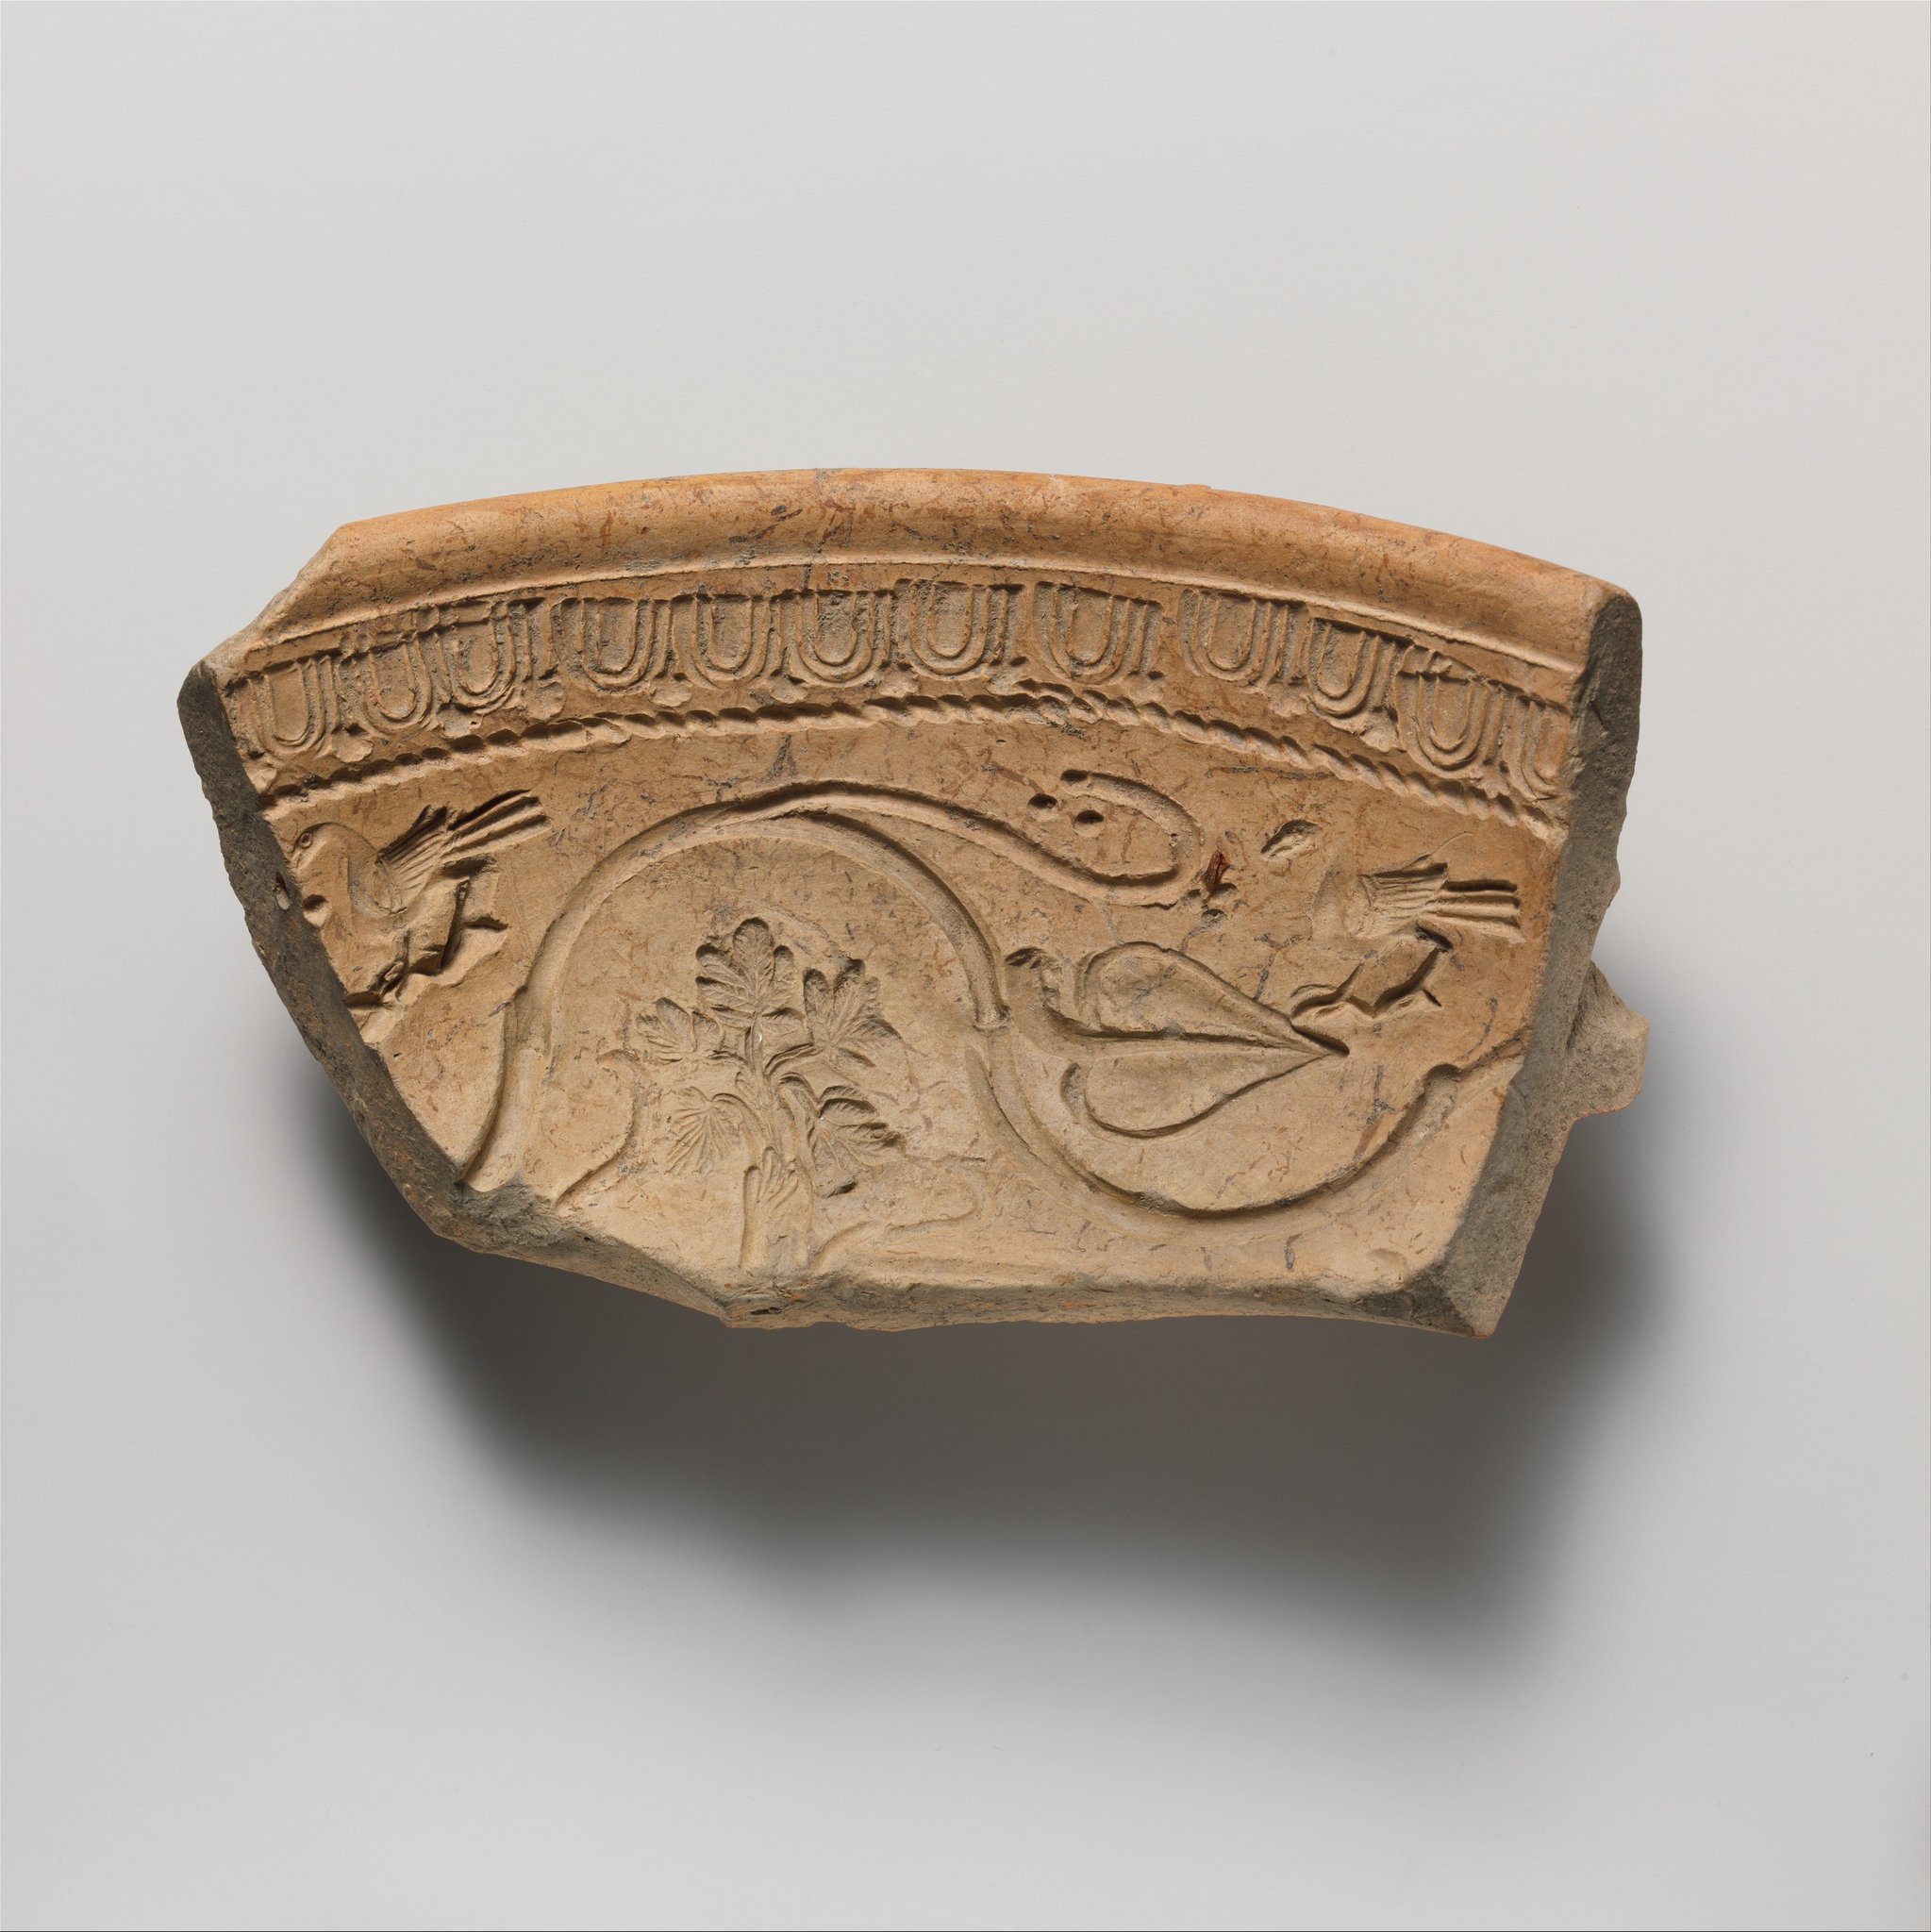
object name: mold fragment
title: Terracotta mold fragment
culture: roman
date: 101-200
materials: terracotta